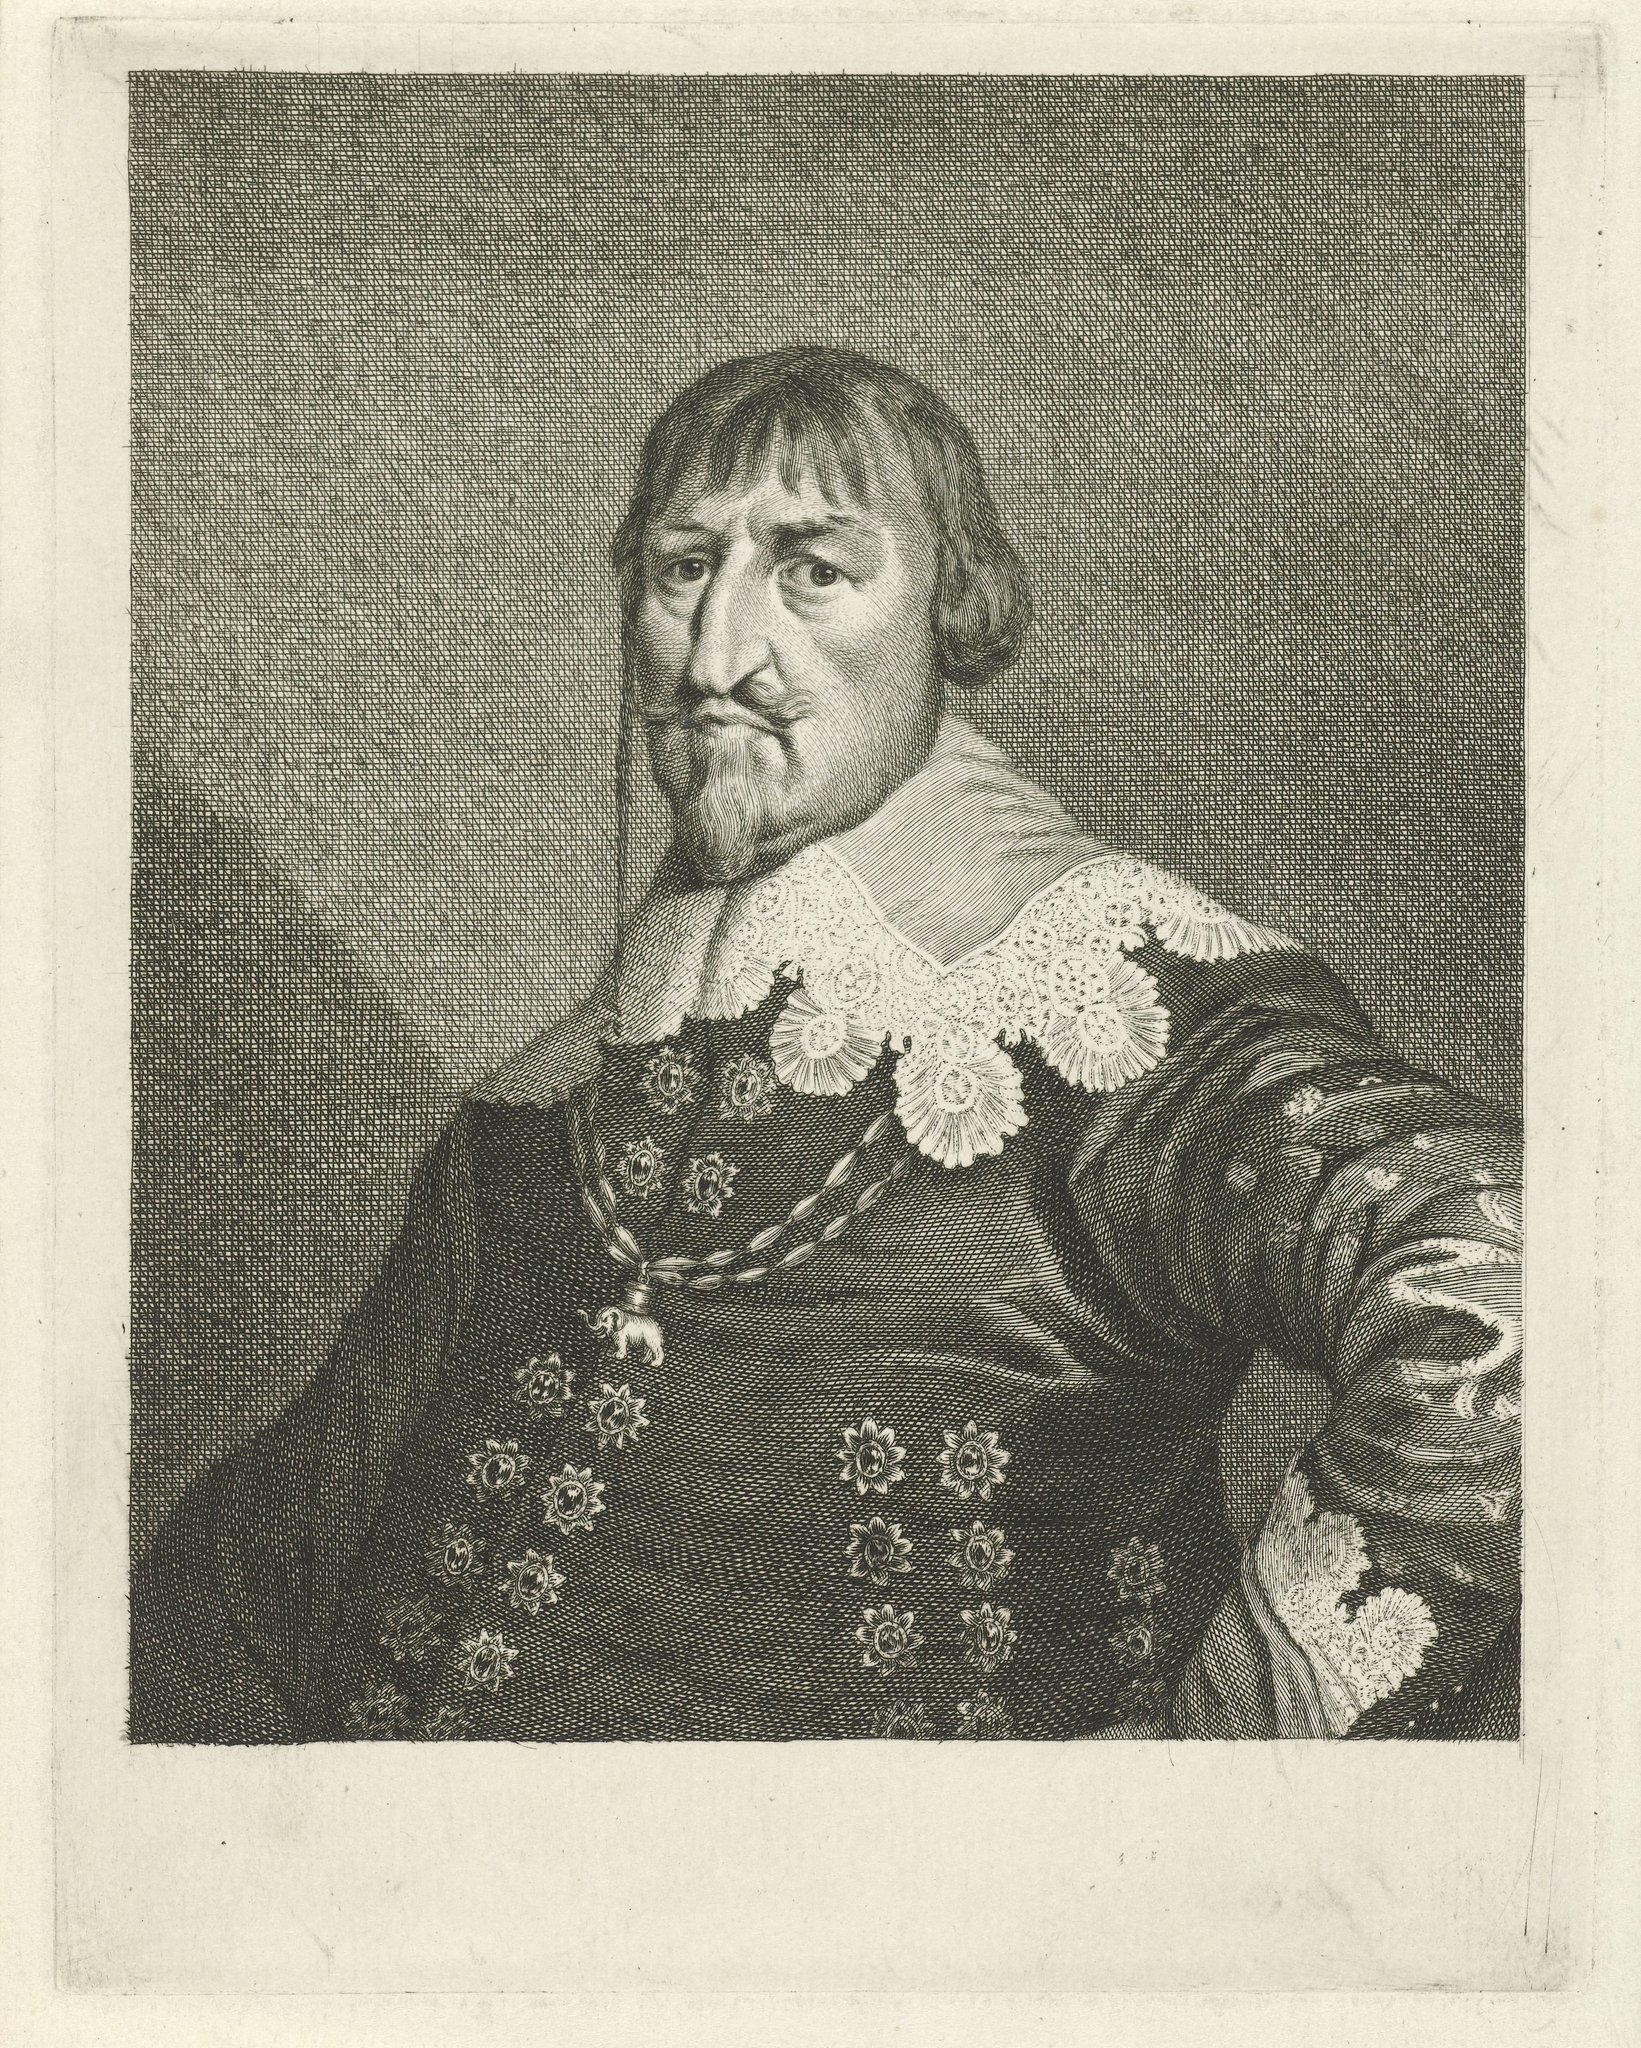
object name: print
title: Portret van Christiaan IV koning van Denemarken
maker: jacob houbraken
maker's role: draughtsman, print maker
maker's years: 1698-1780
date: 1708-1780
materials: paper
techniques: engraving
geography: amsterdam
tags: copenhagen (city), christiaan iv (koning van denemarken en noorwegen), knighthood order of the golden fleece - insignia of a knighthood order, e.g.: badge, chain (with name of order)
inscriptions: collector's mark: Lugt 2228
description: Portret ten halven lijve naar links van Christiaan IV, koning van Denemarken en Noorwegen met om zijn hals het teken van de orde van het Gulden Vlies.